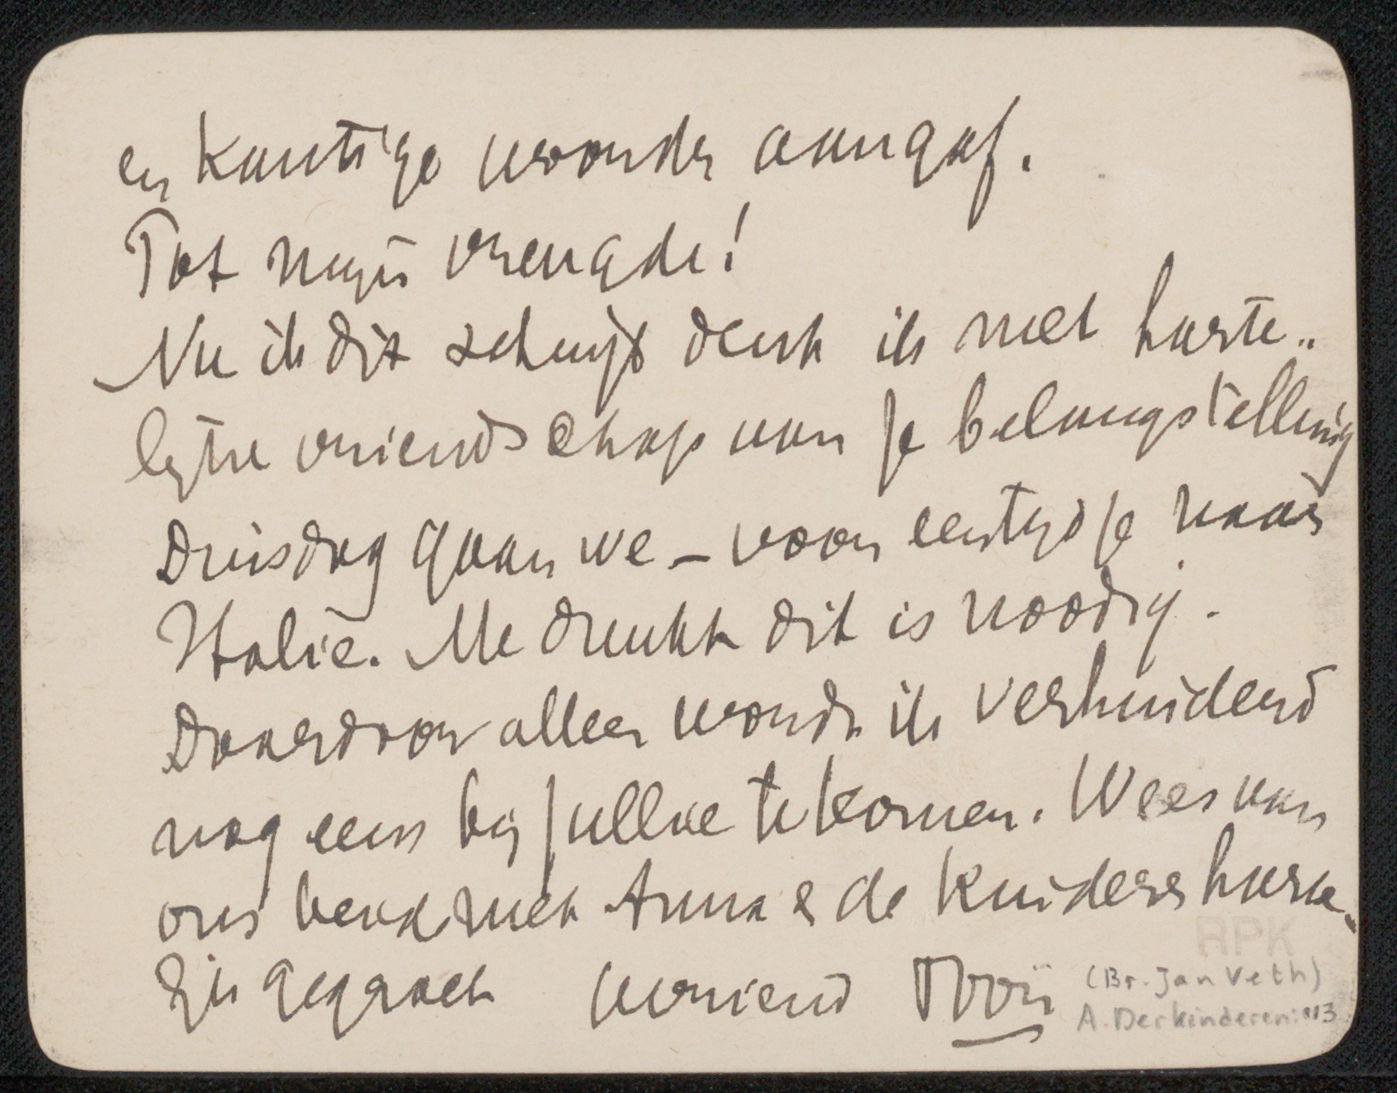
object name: letter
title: Brief aan Jan Veth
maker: antoon derkinderen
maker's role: draughtsman, painter, print maker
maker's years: 1859-1925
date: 1906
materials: cardboard, ink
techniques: pen, writing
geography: laren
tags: the hague, jozef israëls, dordrecht, amsterdam, painter, print maker, draughtsman, designer, jan veth, italy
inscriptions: collector's mark: ‘RPK’